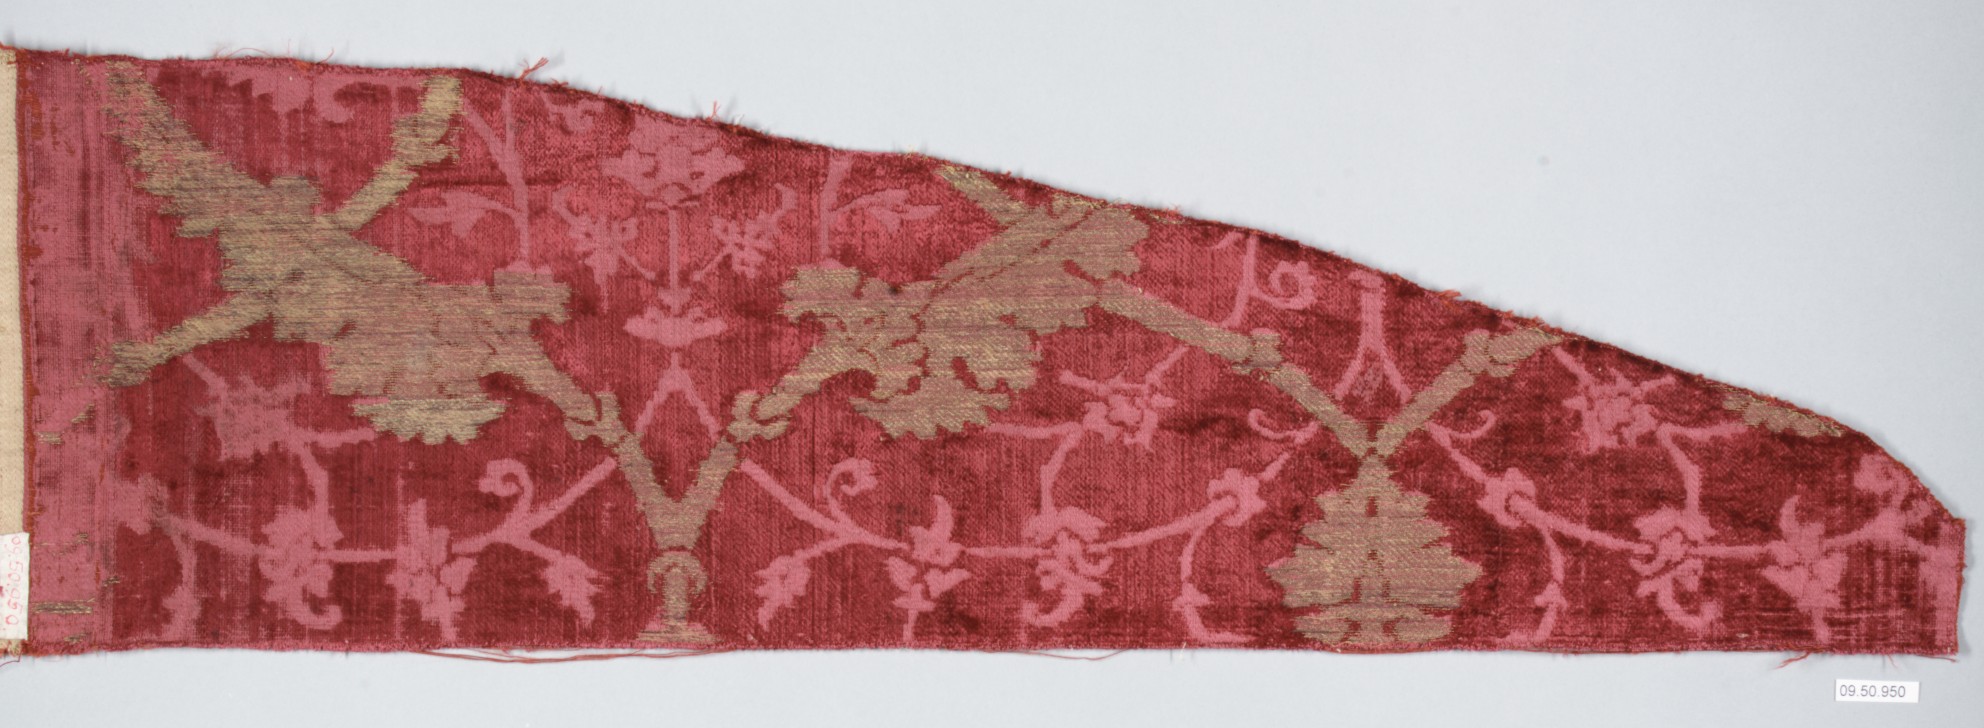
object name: piece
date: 1401-1600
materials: metal thread, silk